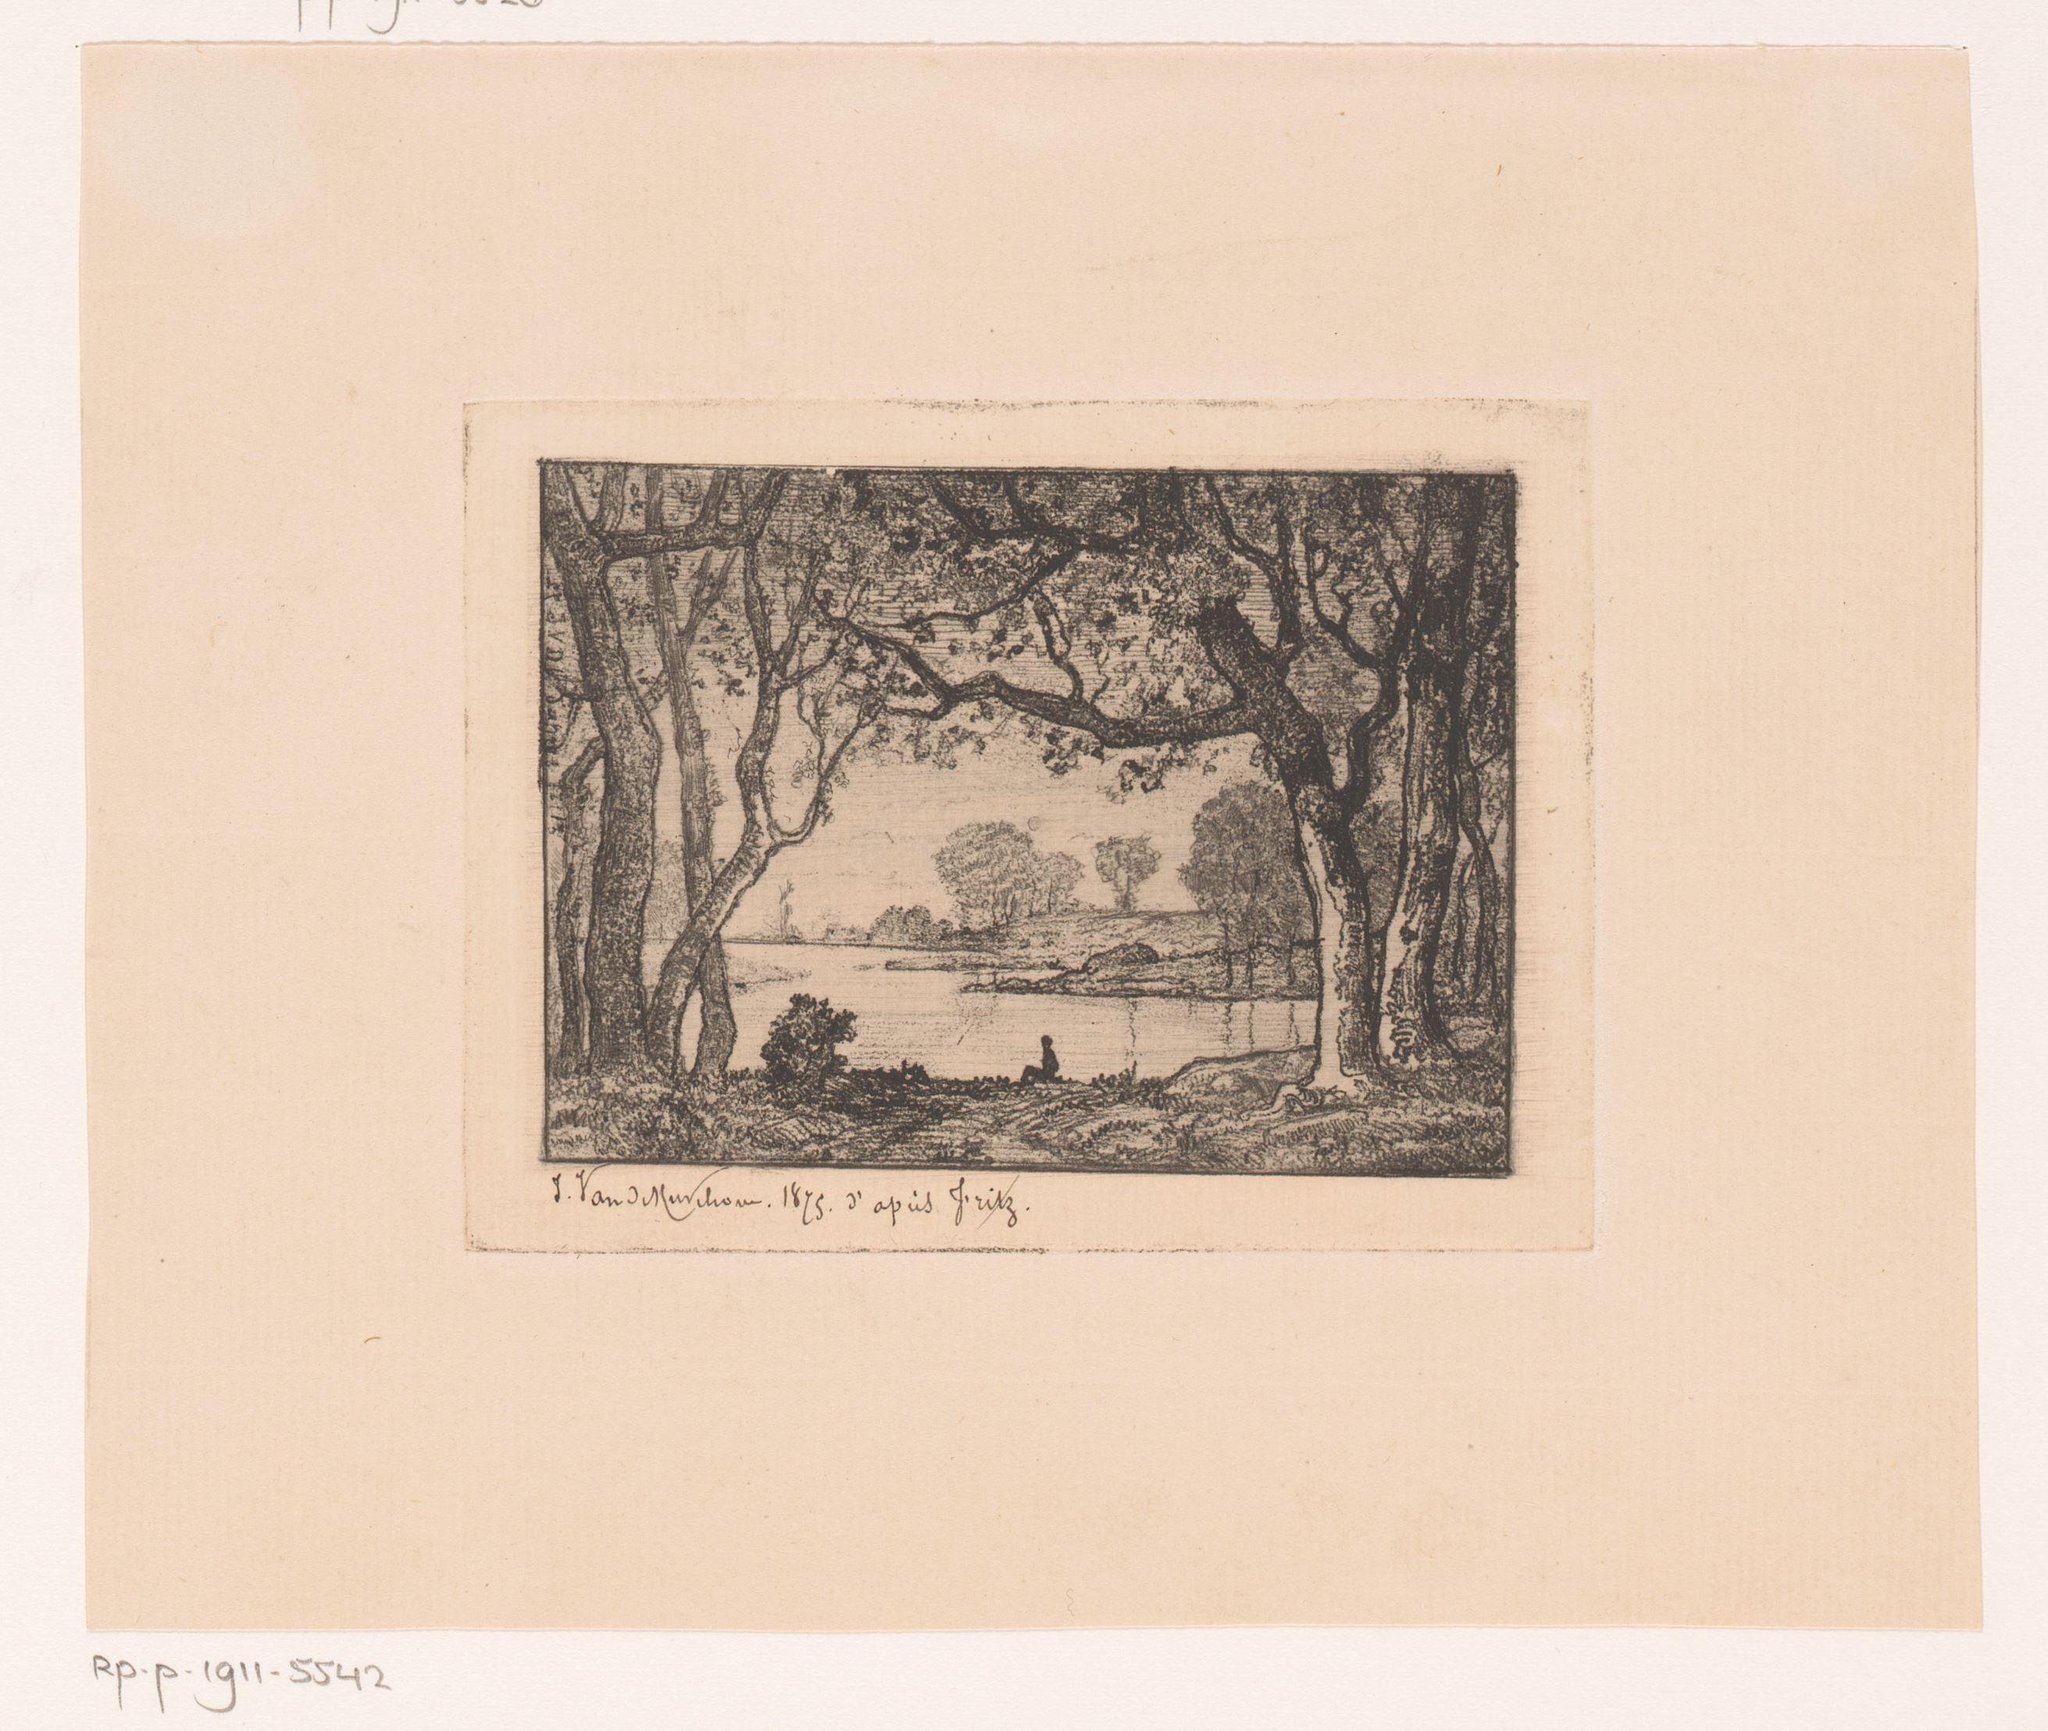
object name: print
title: Boslandschap met figuur op de oever van een vijver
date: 1875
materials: paper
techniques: etching, intaglio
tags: lake, forest, wood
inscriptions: collector's mark: Lugt 2228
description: De etsen naar de schilderijen van Frédéric Van de Kerkhove werden na zijn dood door zijn vader en zuster gemaakt en uitgegeven in twee reeksen. De eerste werd in 1877 uitgegeven door het Journal des Beaux-Arts et de la Littérature: Cahier de 25 Eaux-fortes d'après Frédéric van de Kerkhove, gravées par son père et sa sœur. De tweede reeks van 126 etsen, ook in 1877, werd in Parijs uitgegeven bij A. Lévy onder de titel Cent eaux-fortes gravées par J. Van de Kerkhove d'après les tableaux de Frédéric Van de Kerkhove, mort en 1873 à l'âge de 10 ans et 11 mois.